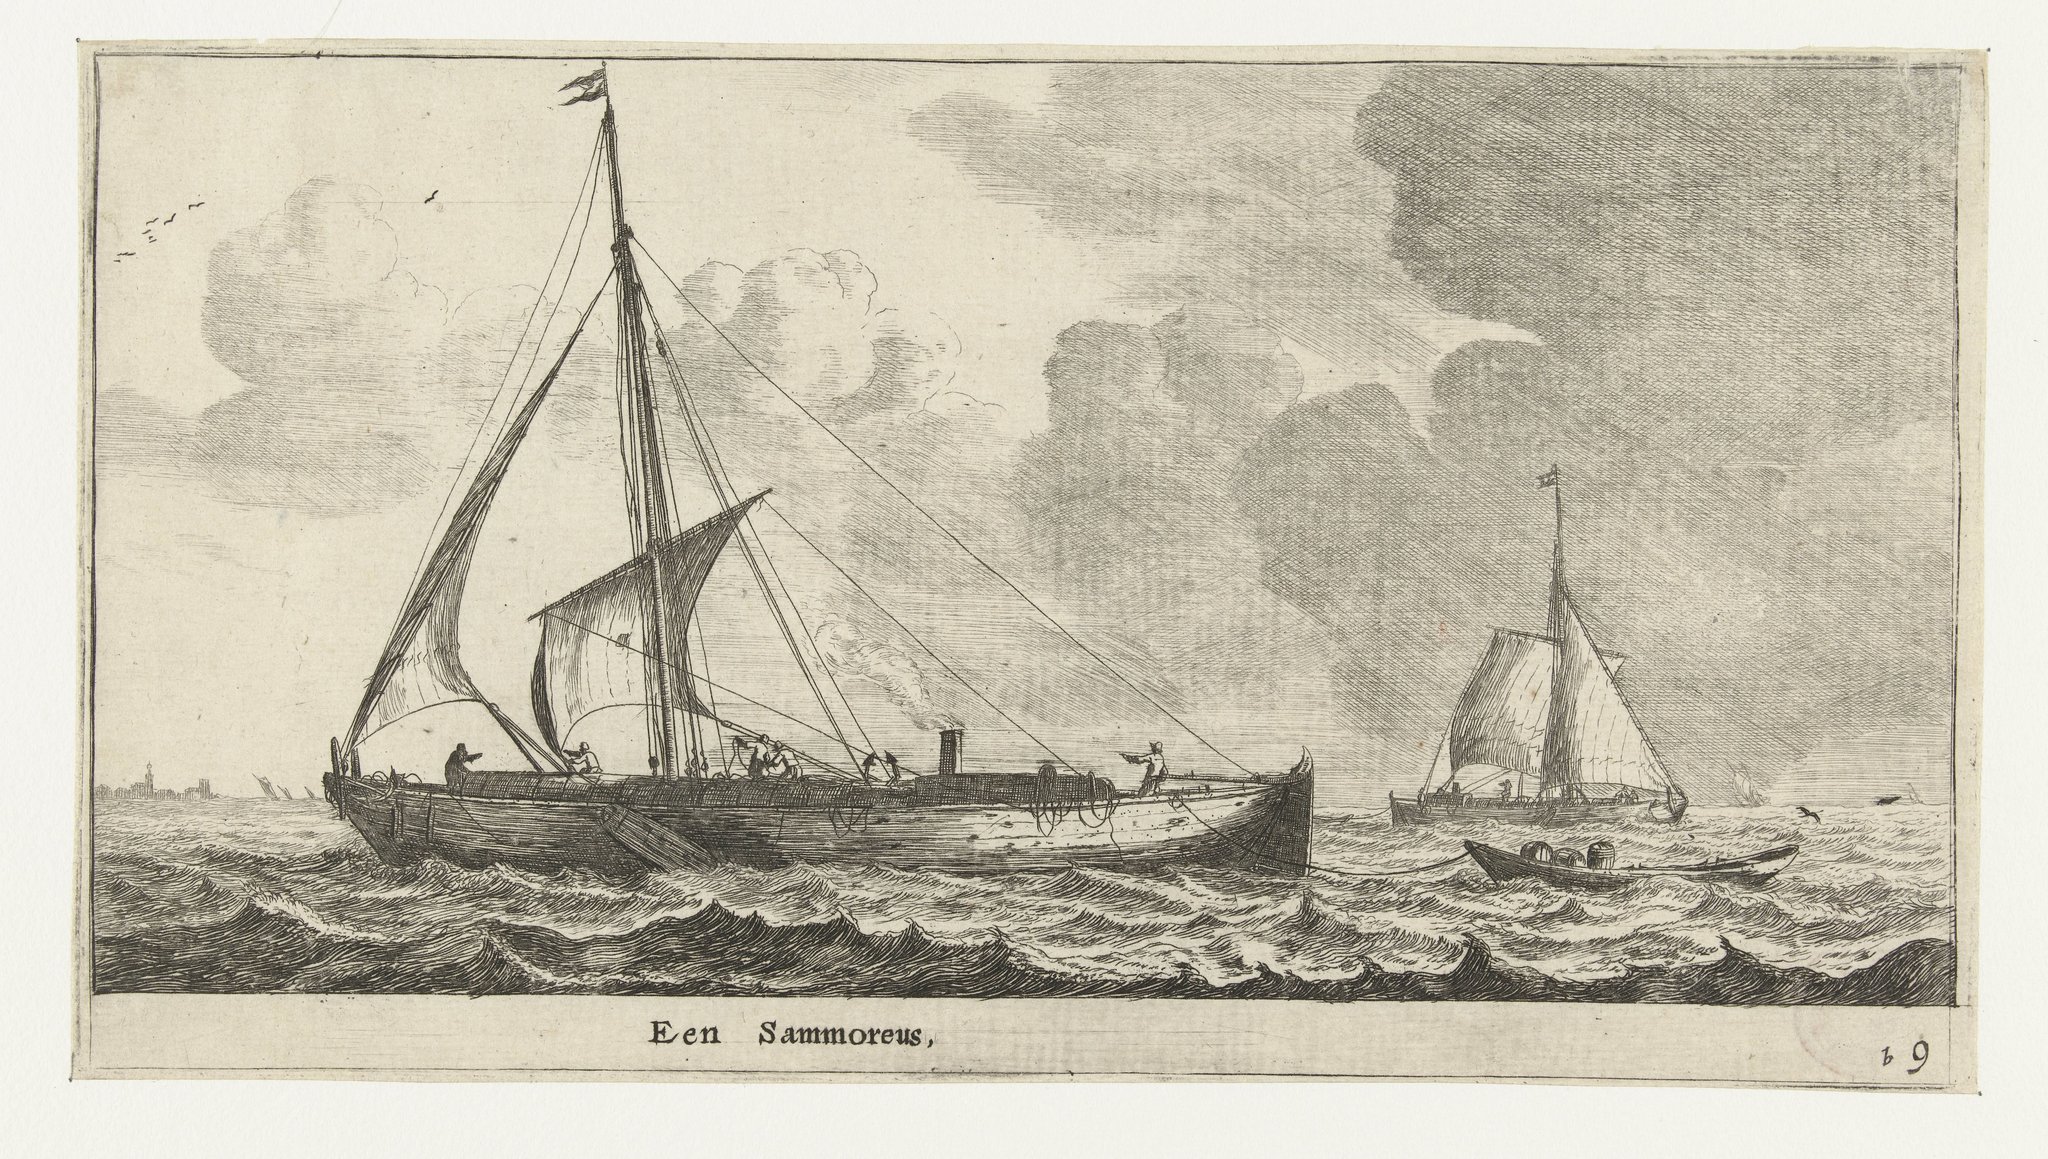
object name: print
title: Verscheyde Schepen en Gesichten van Amstelredam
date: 1652-1654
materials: paper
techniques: drypoint, etching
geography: netherlands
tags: sailing-ship, sailing-boat (with name)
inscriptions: collector's mark (false): Lugt 12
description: Een Samoreus, een in de streek van Keulen gebouwde rijnaak.